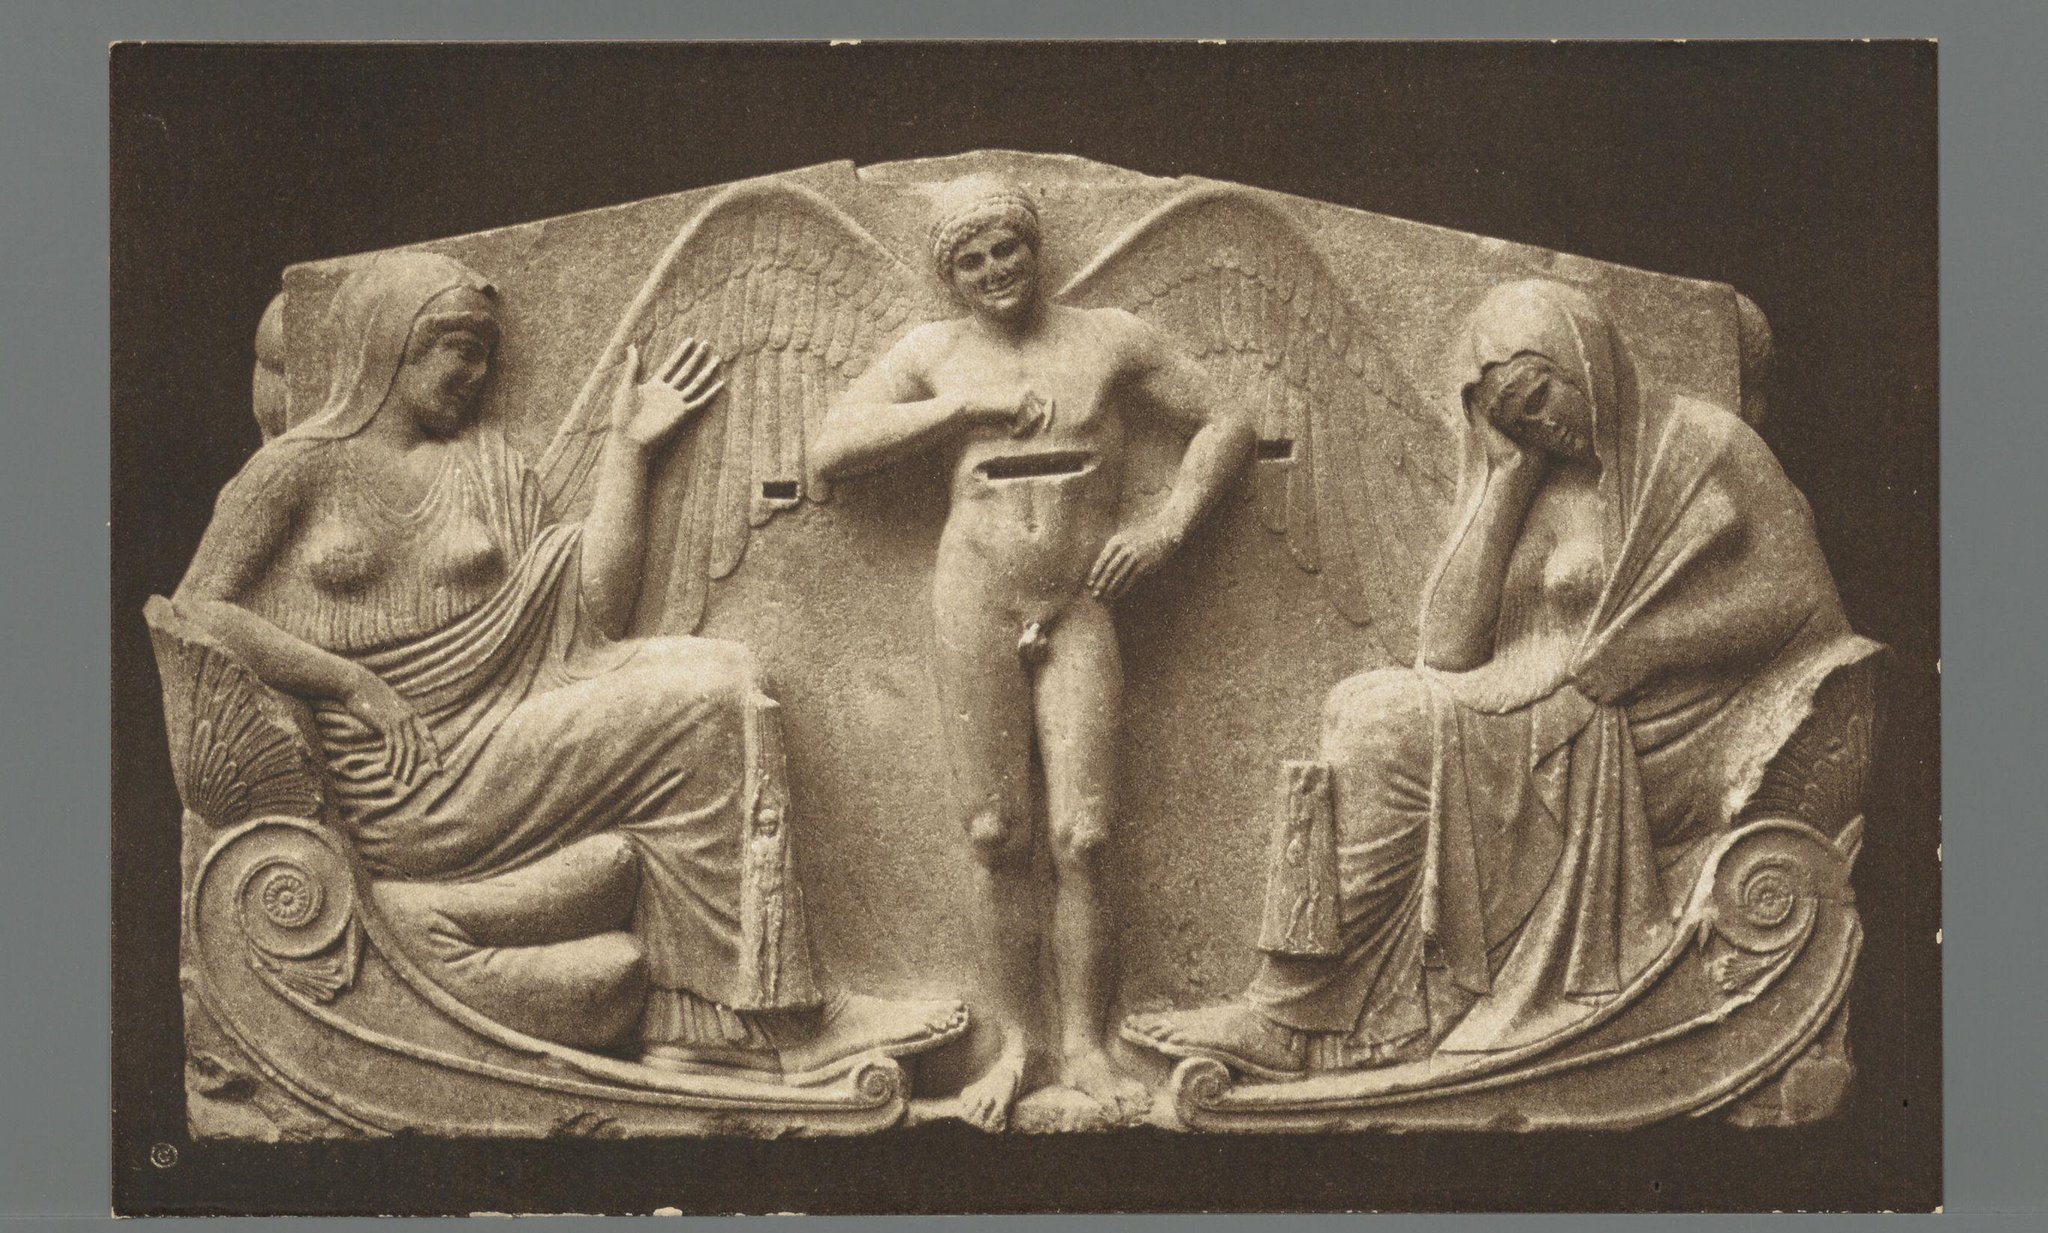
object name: photomechanical print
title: Fifth Century Altar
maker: Anonymous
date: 1920-1936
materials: cardboard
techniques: photograph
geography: boston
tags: art (+ relief ~ sculpture), angels